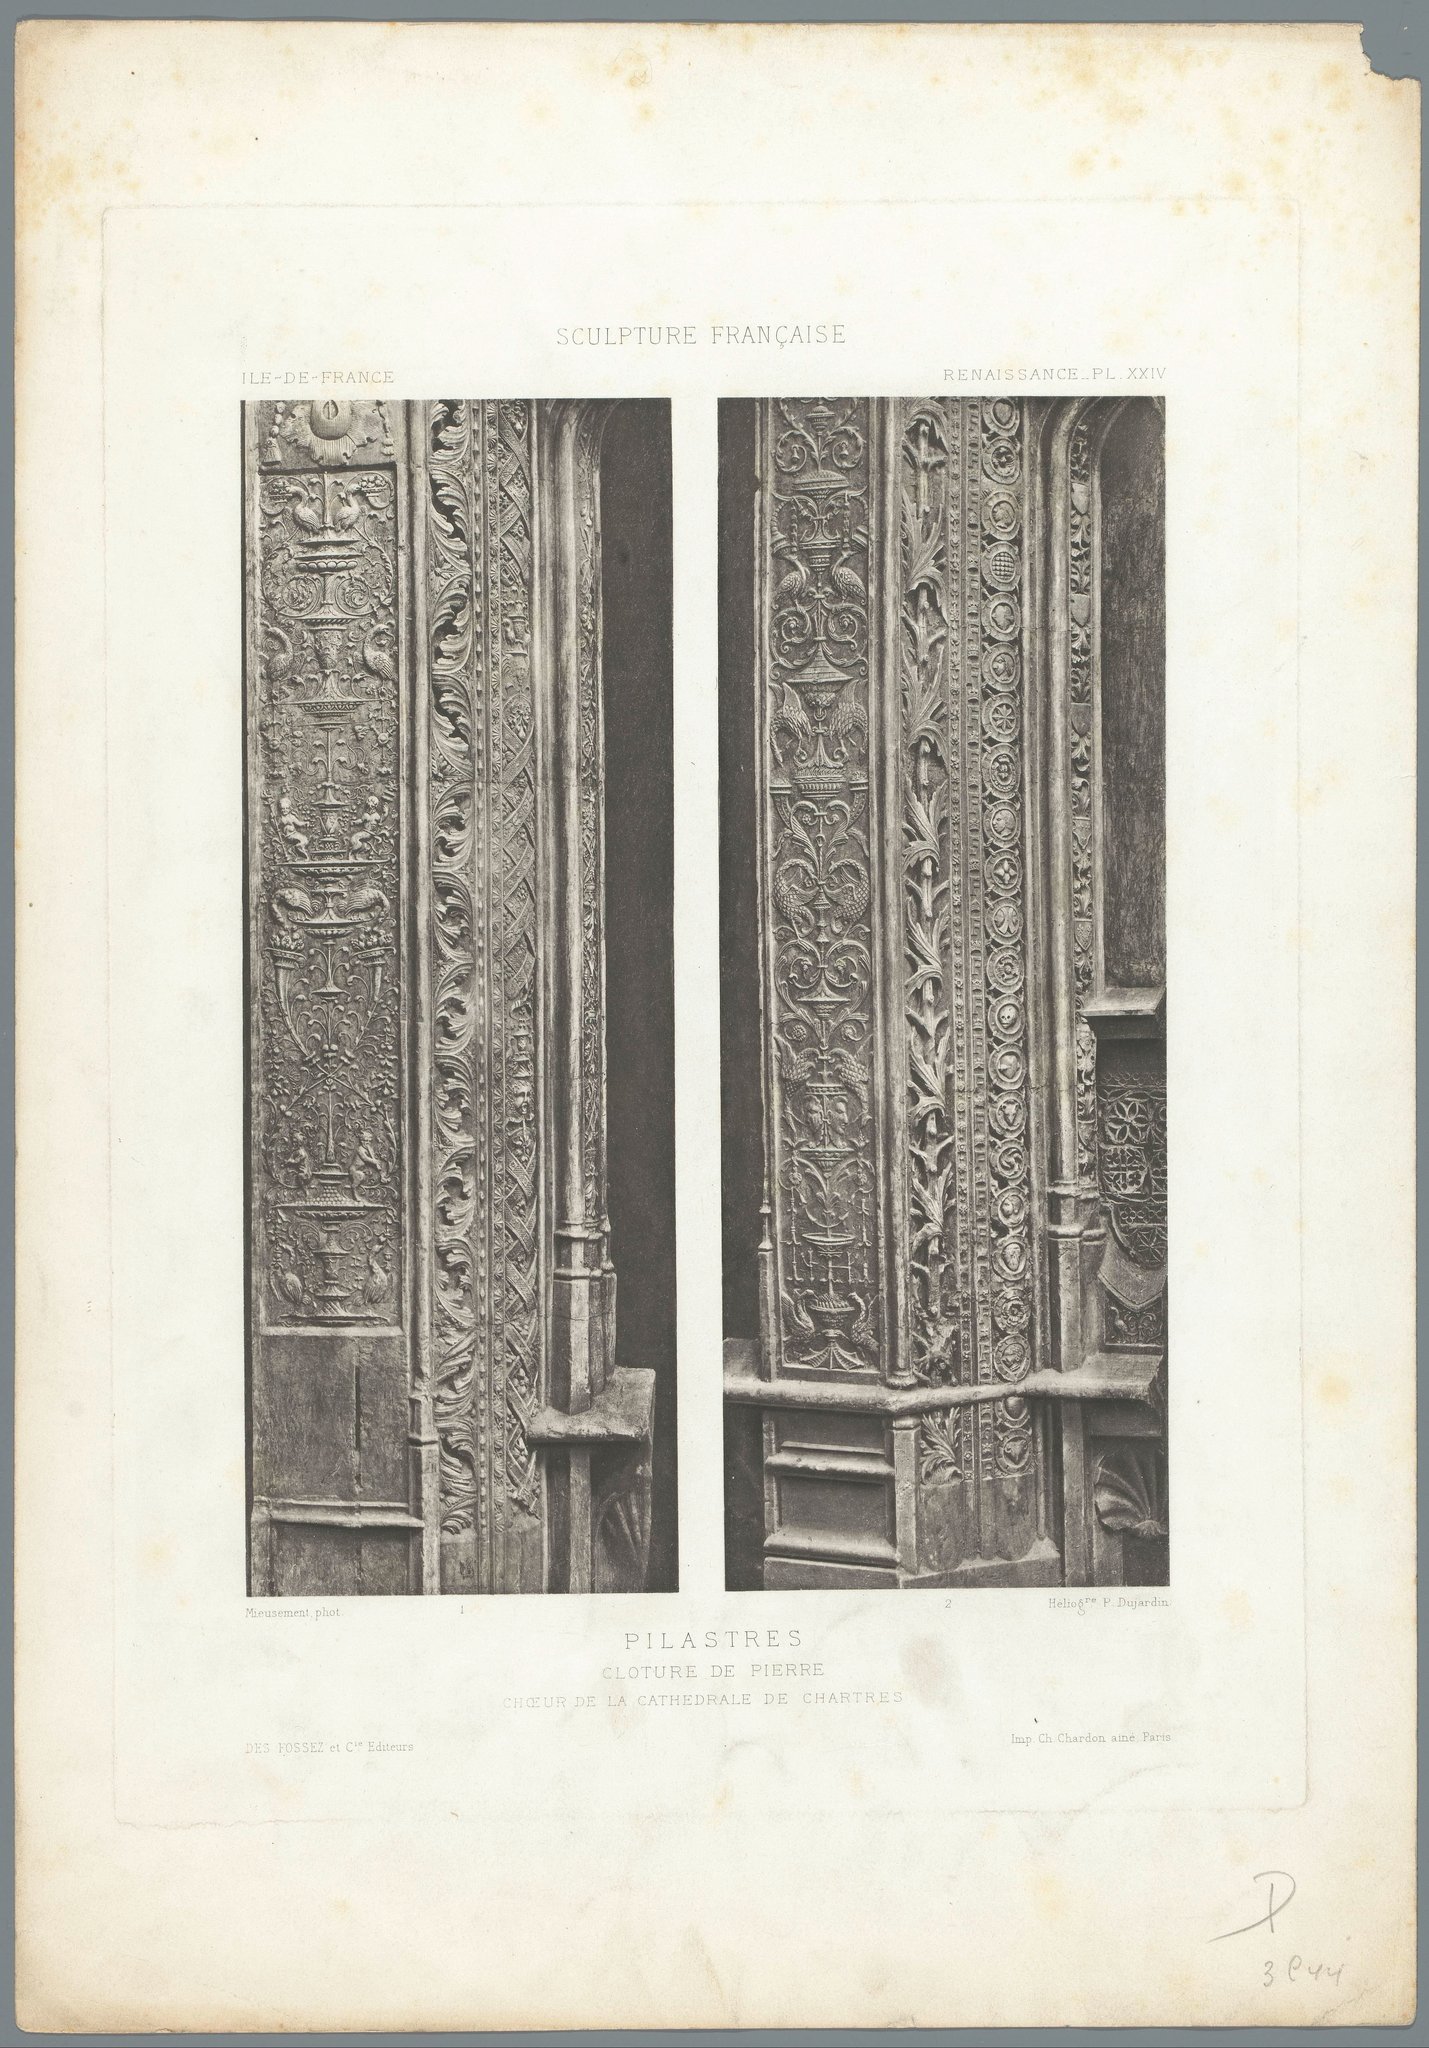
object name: photograph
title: Twee pilasters uit de kathedraal van Chartres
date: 1875-1900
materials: paper, ink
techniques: photoaquatint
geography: europe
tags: ornament derived from plant forms, sculpture (+ relief ~ sculpture)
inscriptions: inscription: ‘SCULPTURE FRANÇAISE ILE-DE-FRANCE RENAISSANCE_PL.XXIV’, collector's mark: Lugt 3937